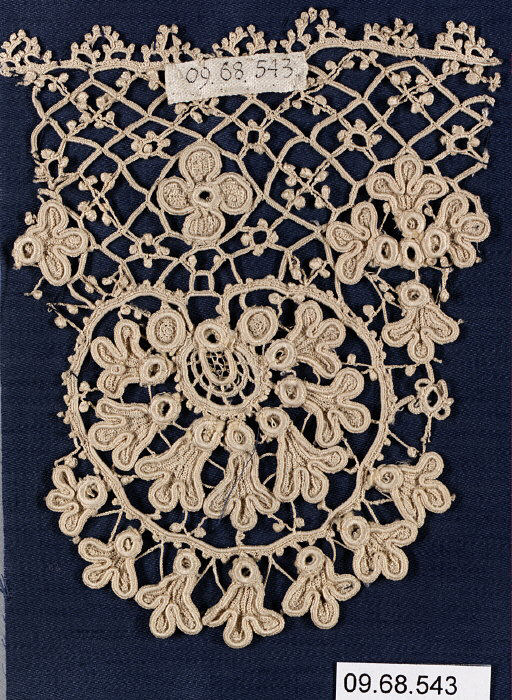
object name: specimen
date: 1801-1900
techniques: crochet